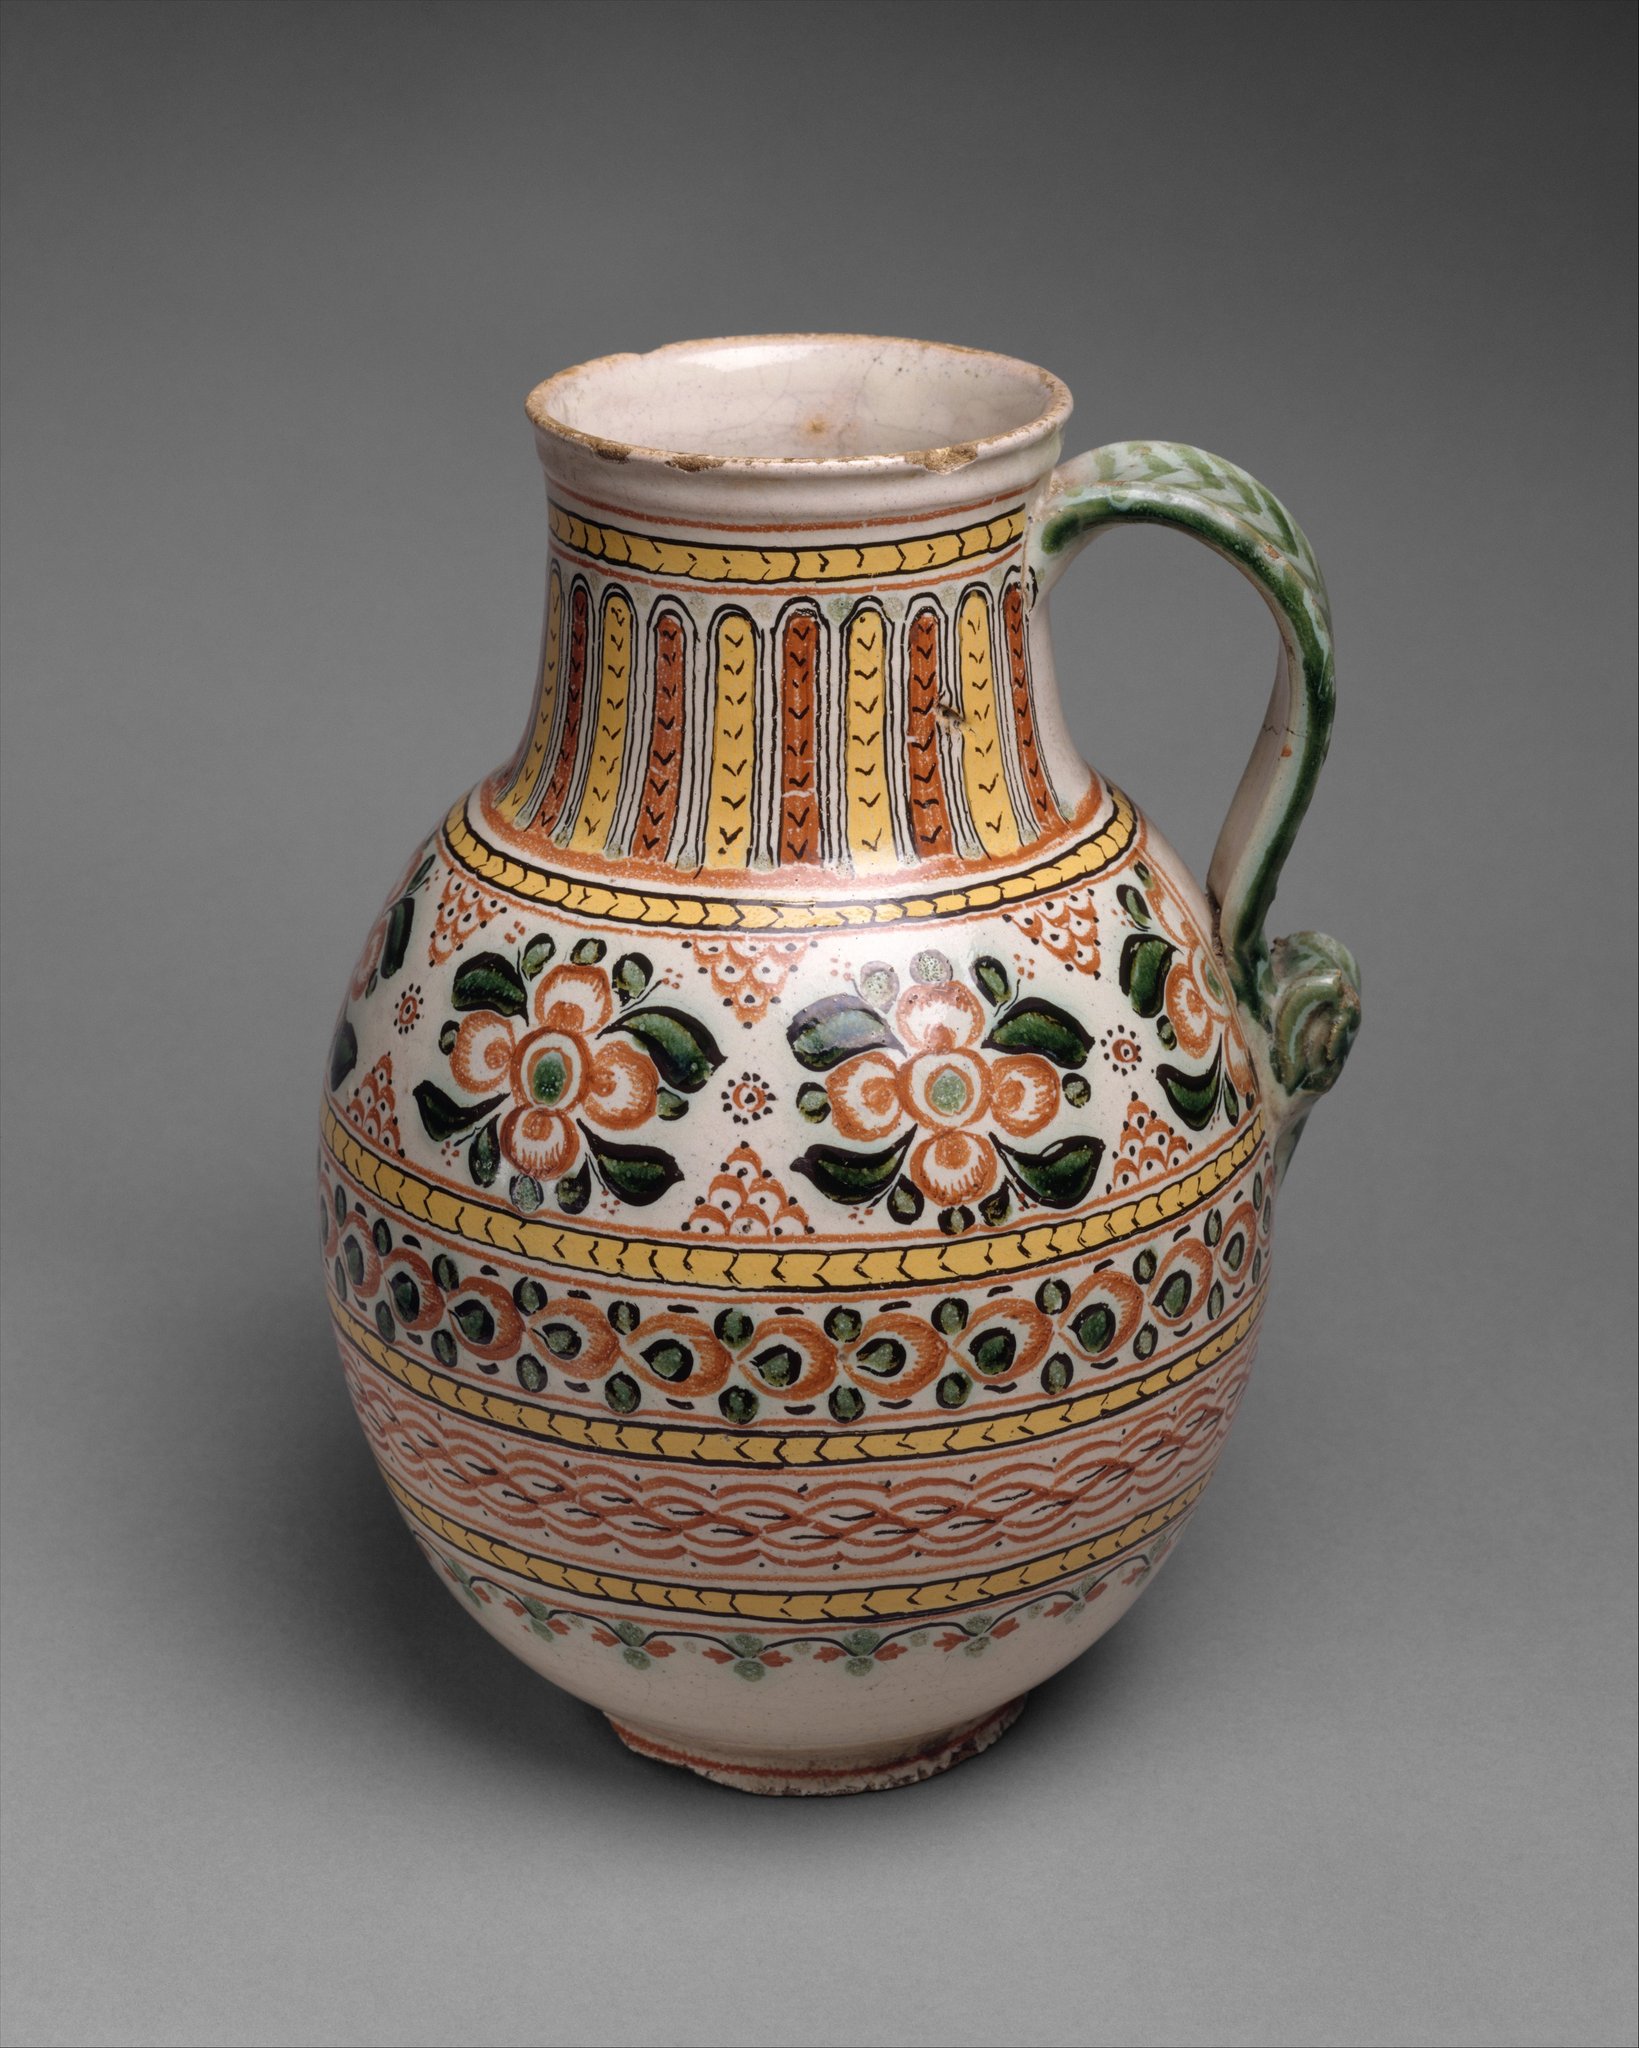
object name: jug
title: Jar with crolled handle and horizontal bands of floral polychrome motifs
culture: mexican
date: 1801-1833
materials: earthenware, tin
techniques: glazing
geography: mexico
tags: flowers